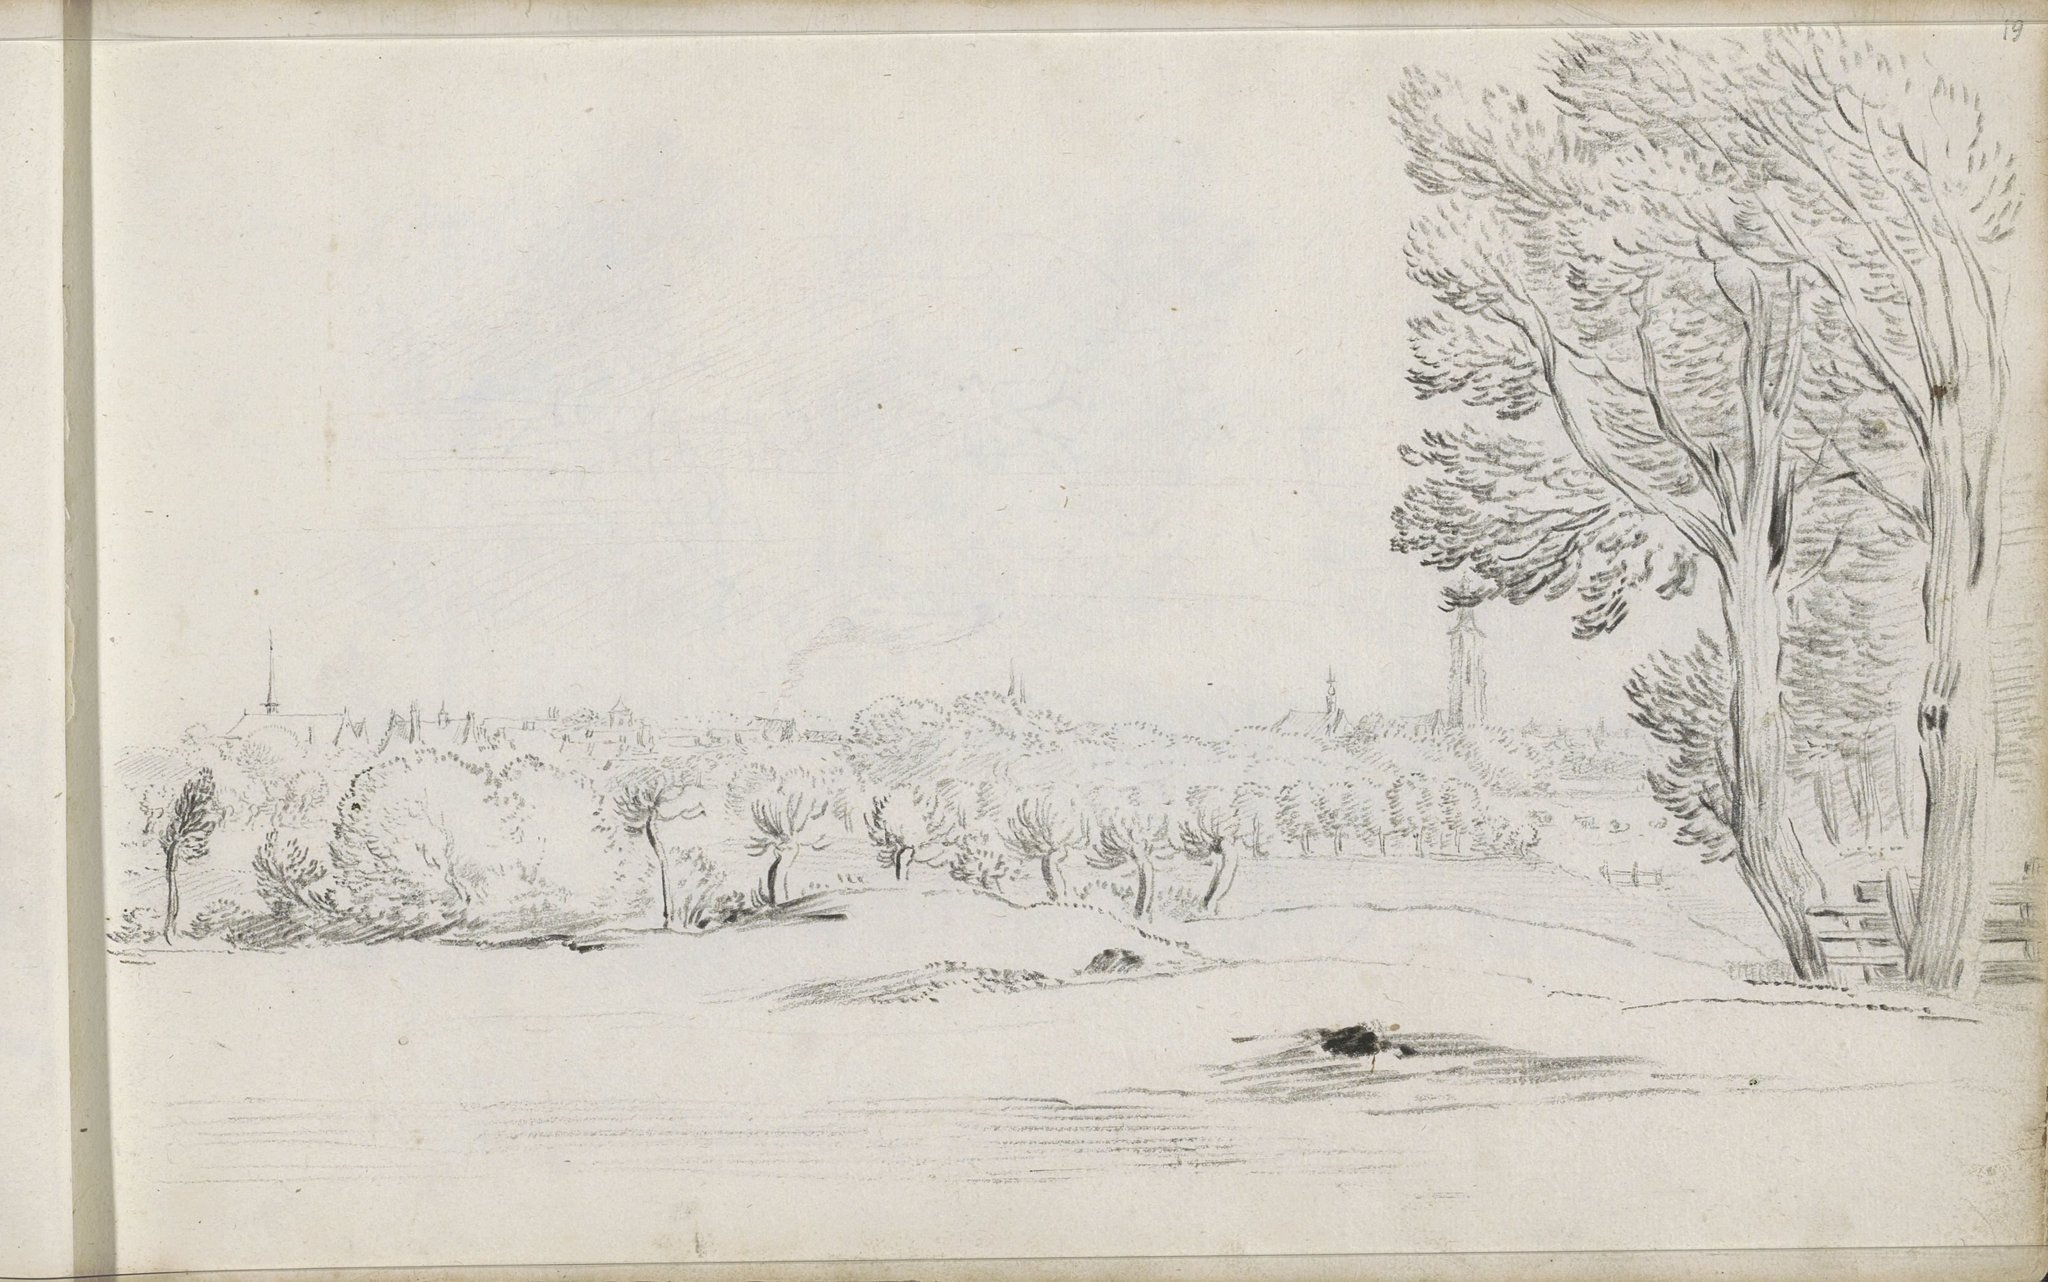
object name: sketchbook leaf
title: Gezicht op Den Haag met de Grote of St. Jacobskerk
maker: pieter moninckx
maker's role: draughtsman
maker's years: 1606-1686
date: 1645-1646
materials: chalk, paper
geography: the hague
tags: prospect of city, town panorama, silhouette of city, the hague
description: Blad 19 recto uit een schetsboek met 39 bladen.